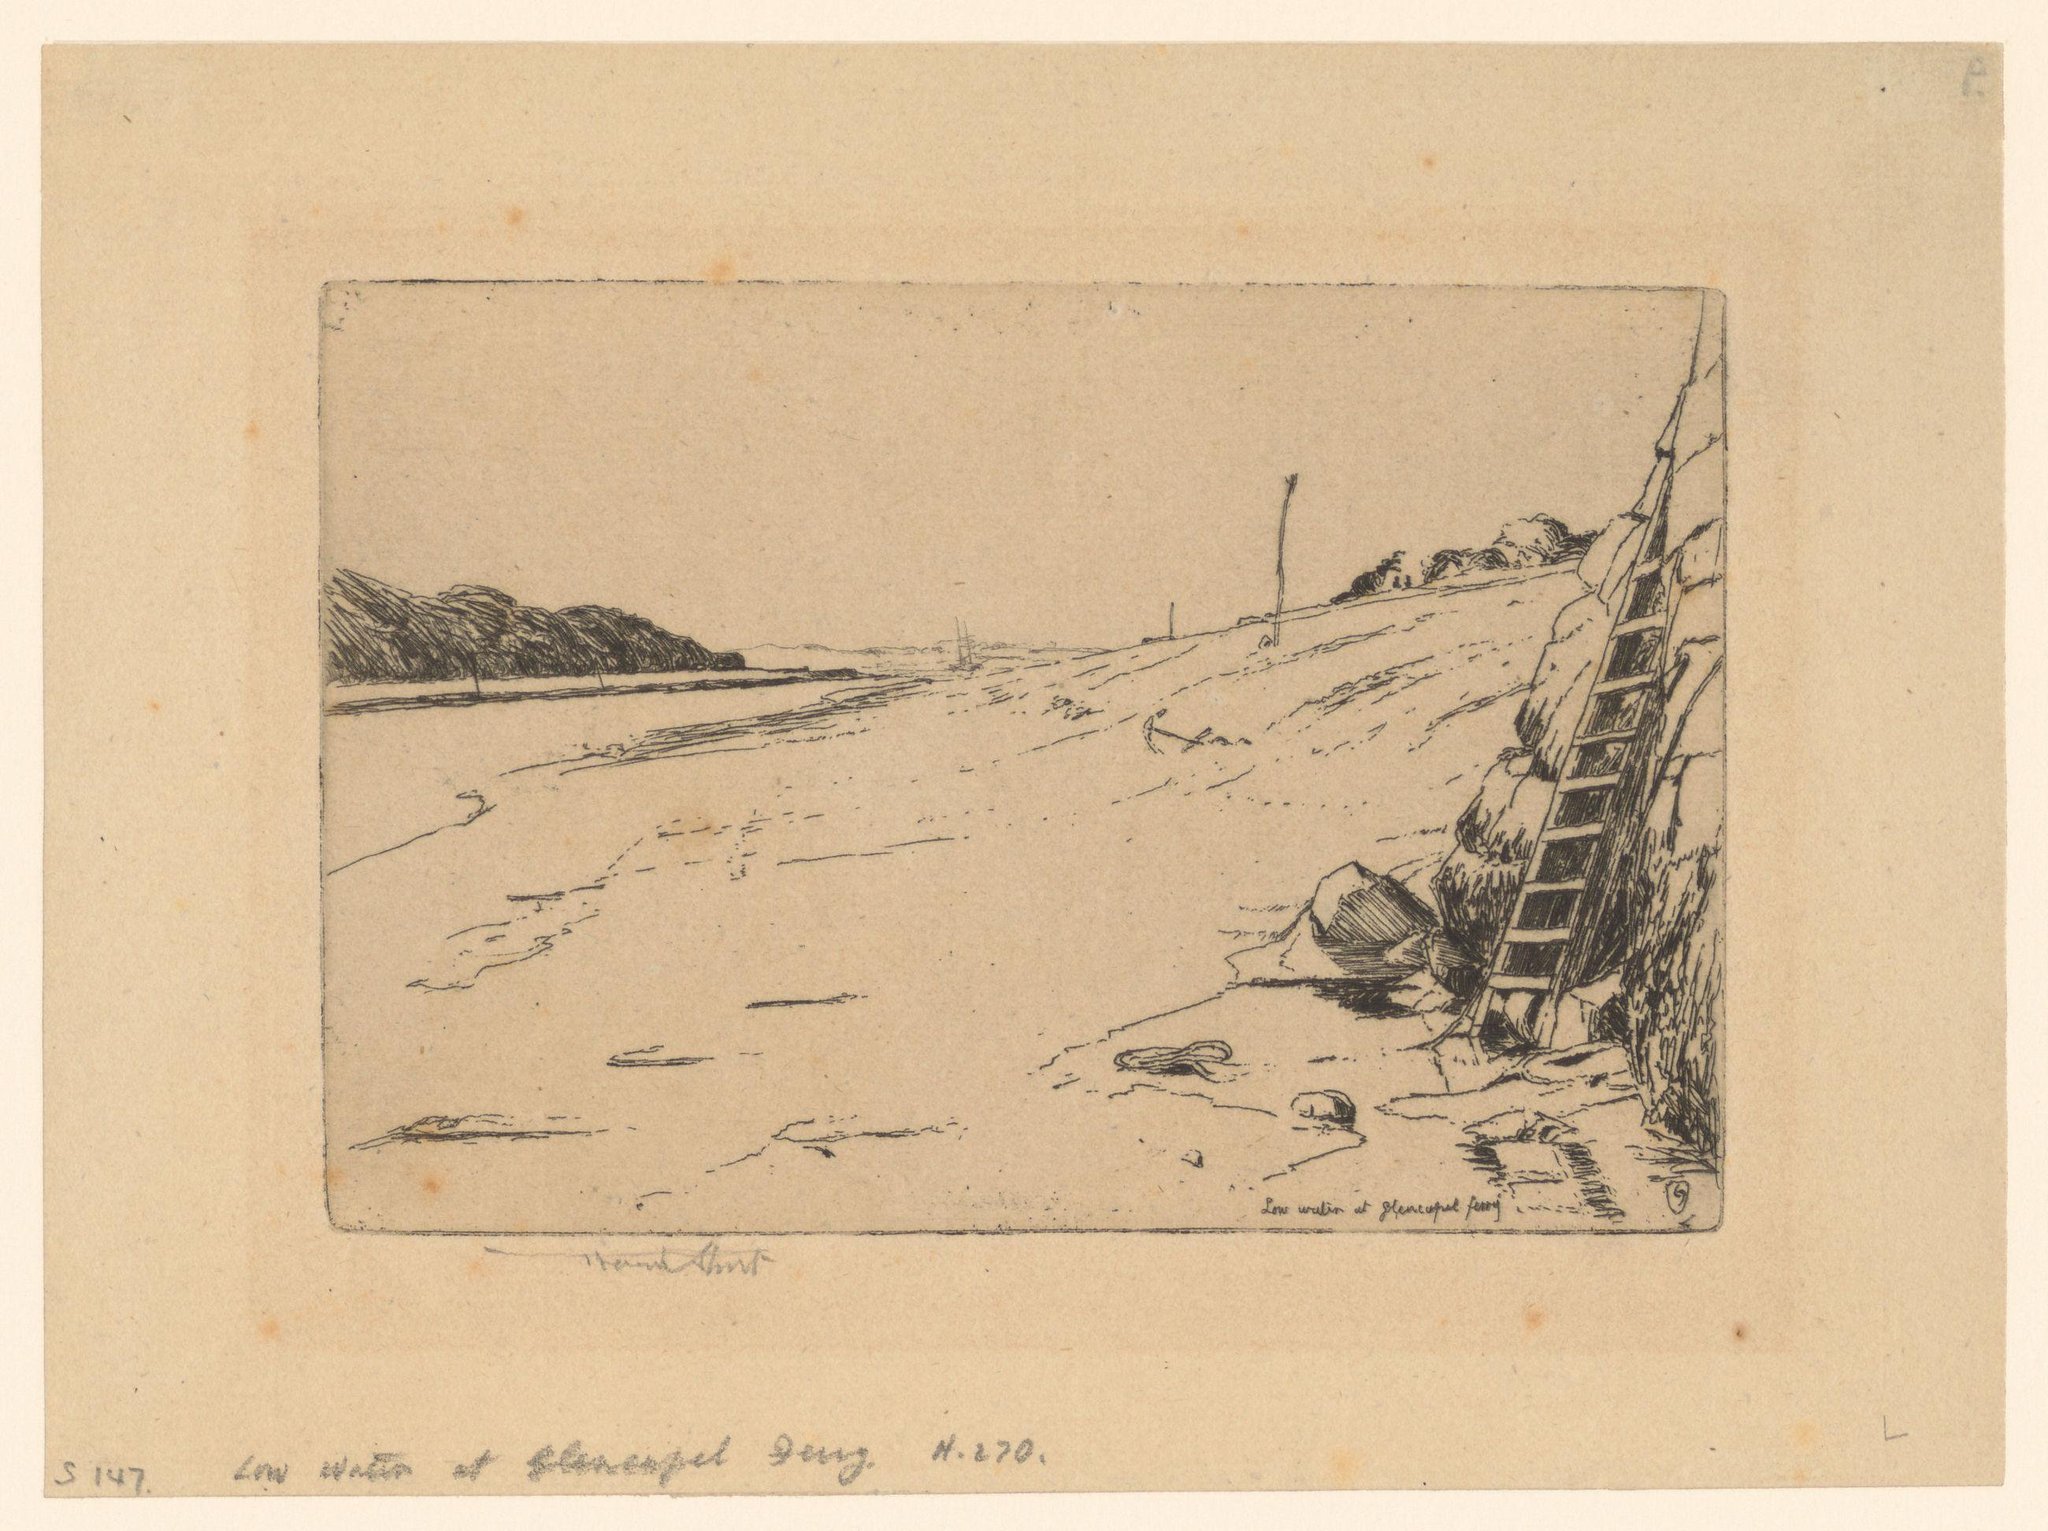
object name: print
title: Oever van de rivier Nith te Glencaple bij laag water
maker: frank short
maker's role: print maker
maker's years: 1857-1945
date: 1892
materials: paper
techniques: etching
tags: river bank, ladder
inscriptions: signature: ‘Frank Short’, collector's mark: Lugt 2228